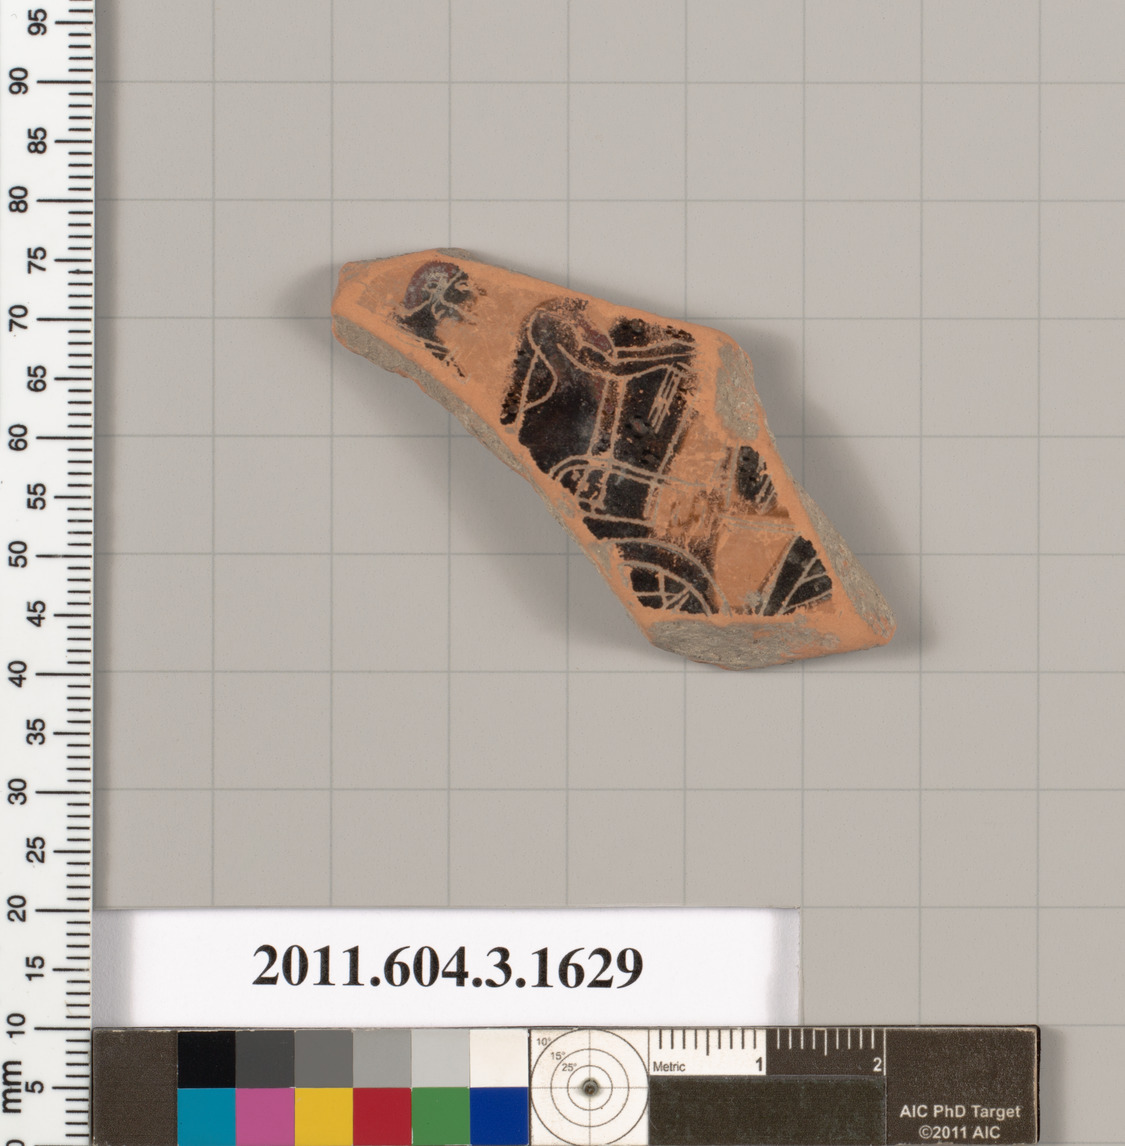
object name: kylix fragment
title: Terracotta fragment of a kylix: Band cup (drinking cup)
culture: greek, attic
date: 567-535 BCE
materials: terracotta